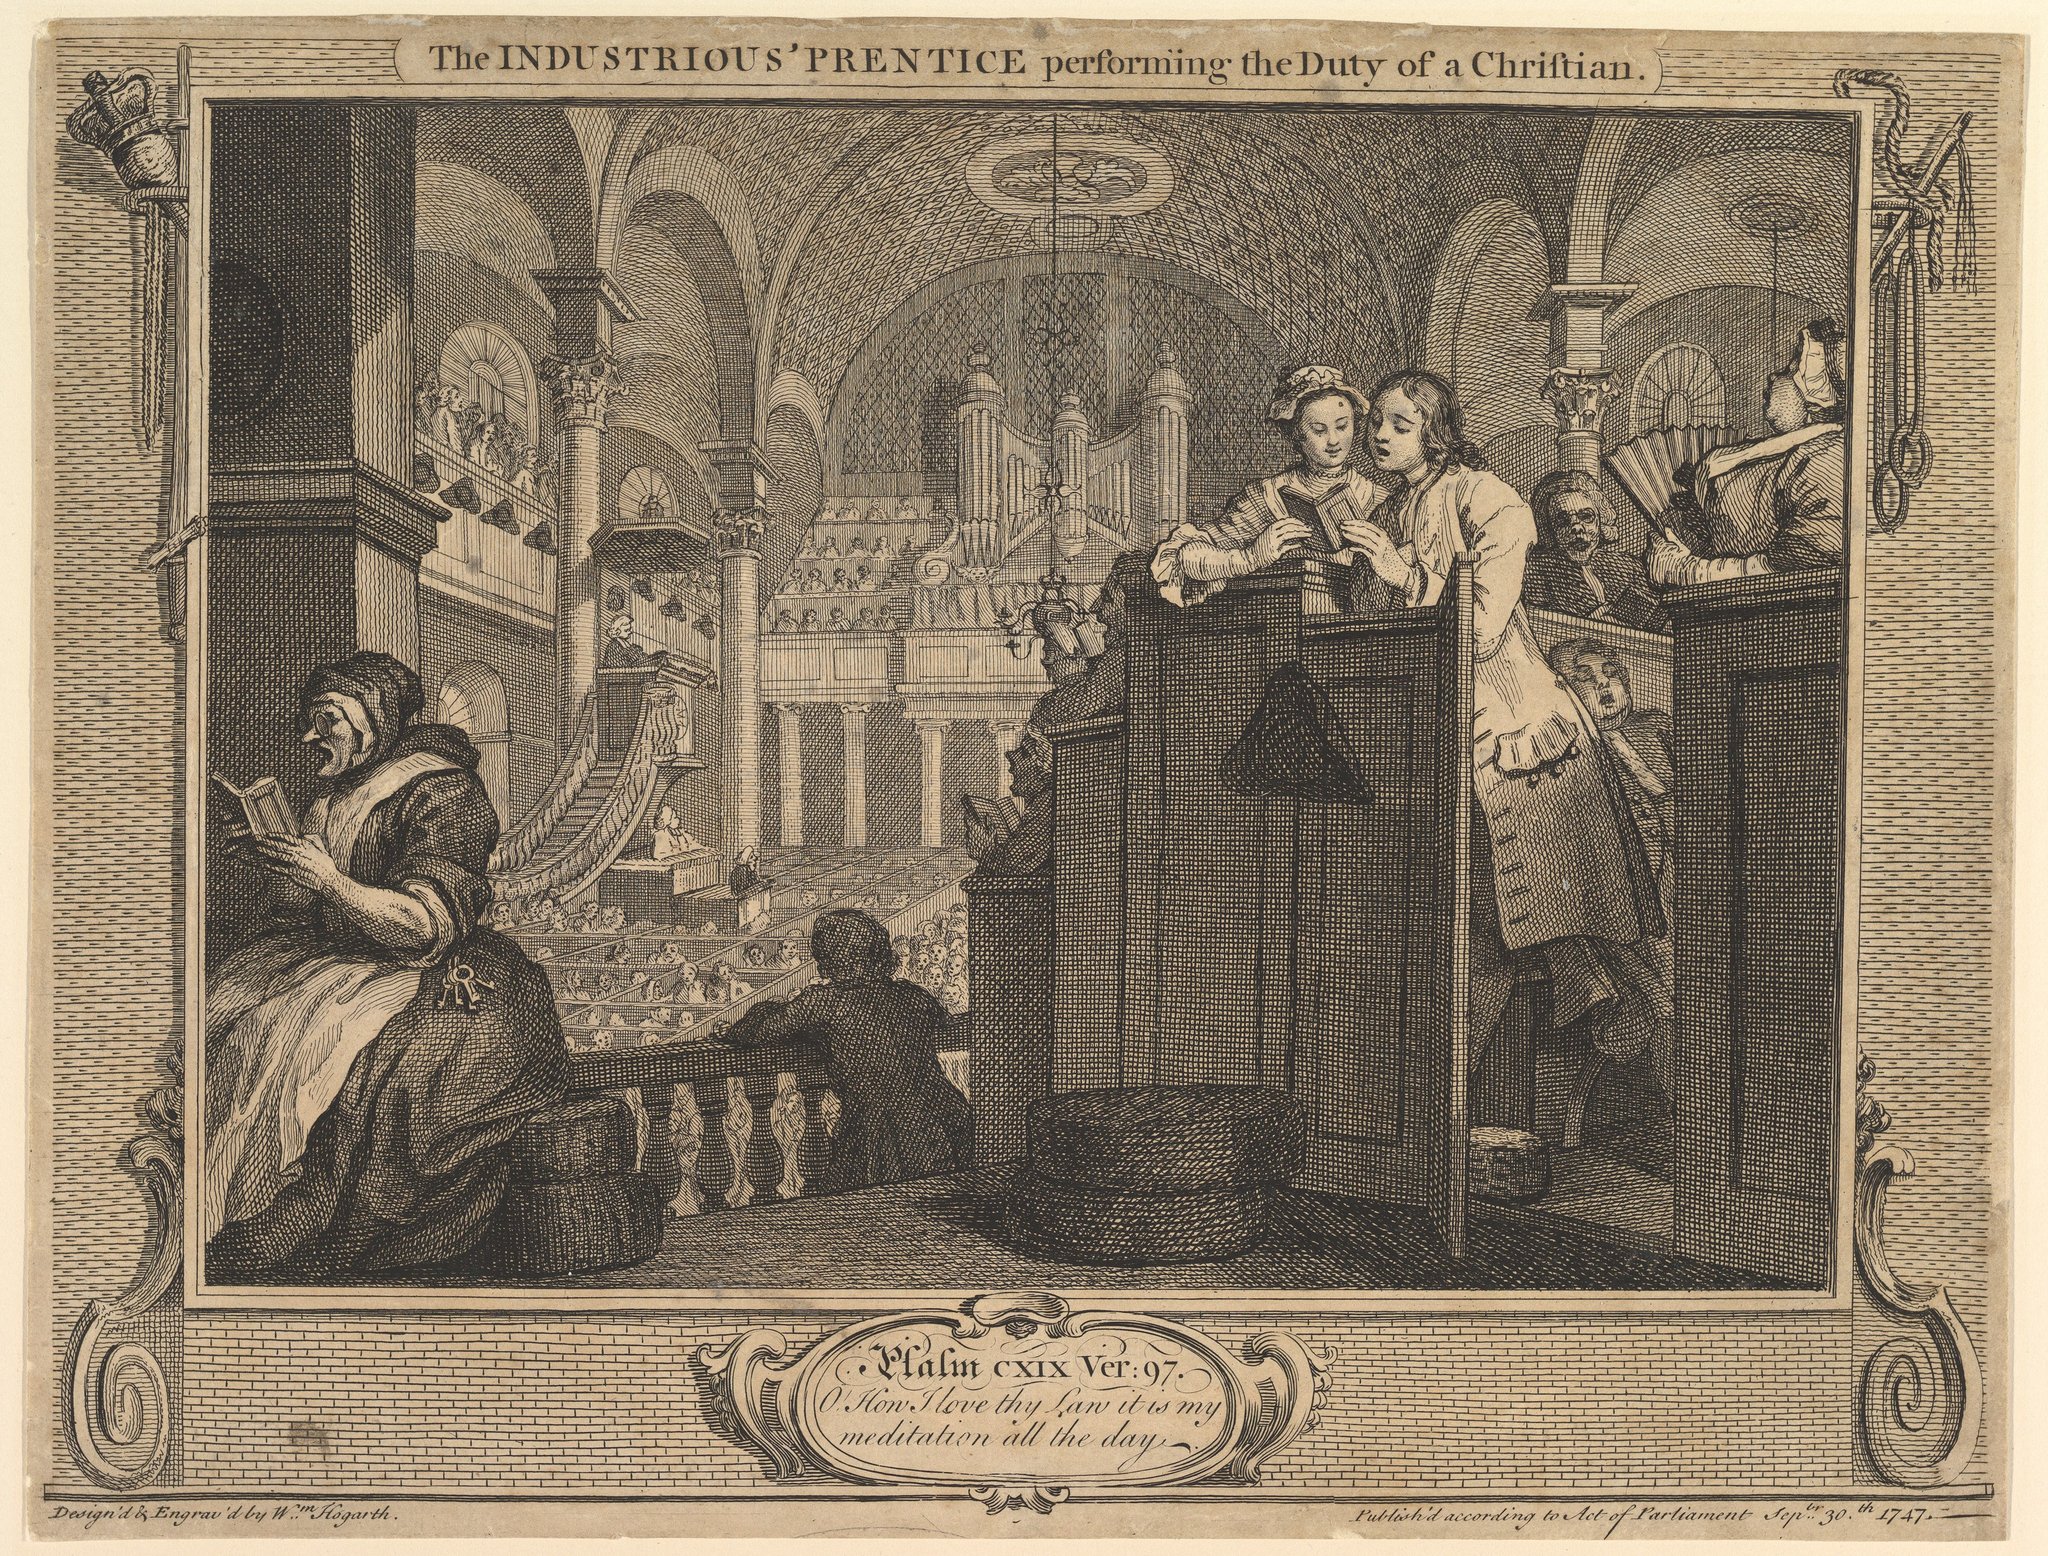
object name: print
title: The Industrious 'Prentice Performing the Duty of a Christian: Industry and Idleness, plate 2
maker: william hogarth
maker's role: artist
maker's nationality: british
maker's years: 1697-1764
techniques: engraving, etching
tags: performance,women,spectators,reading